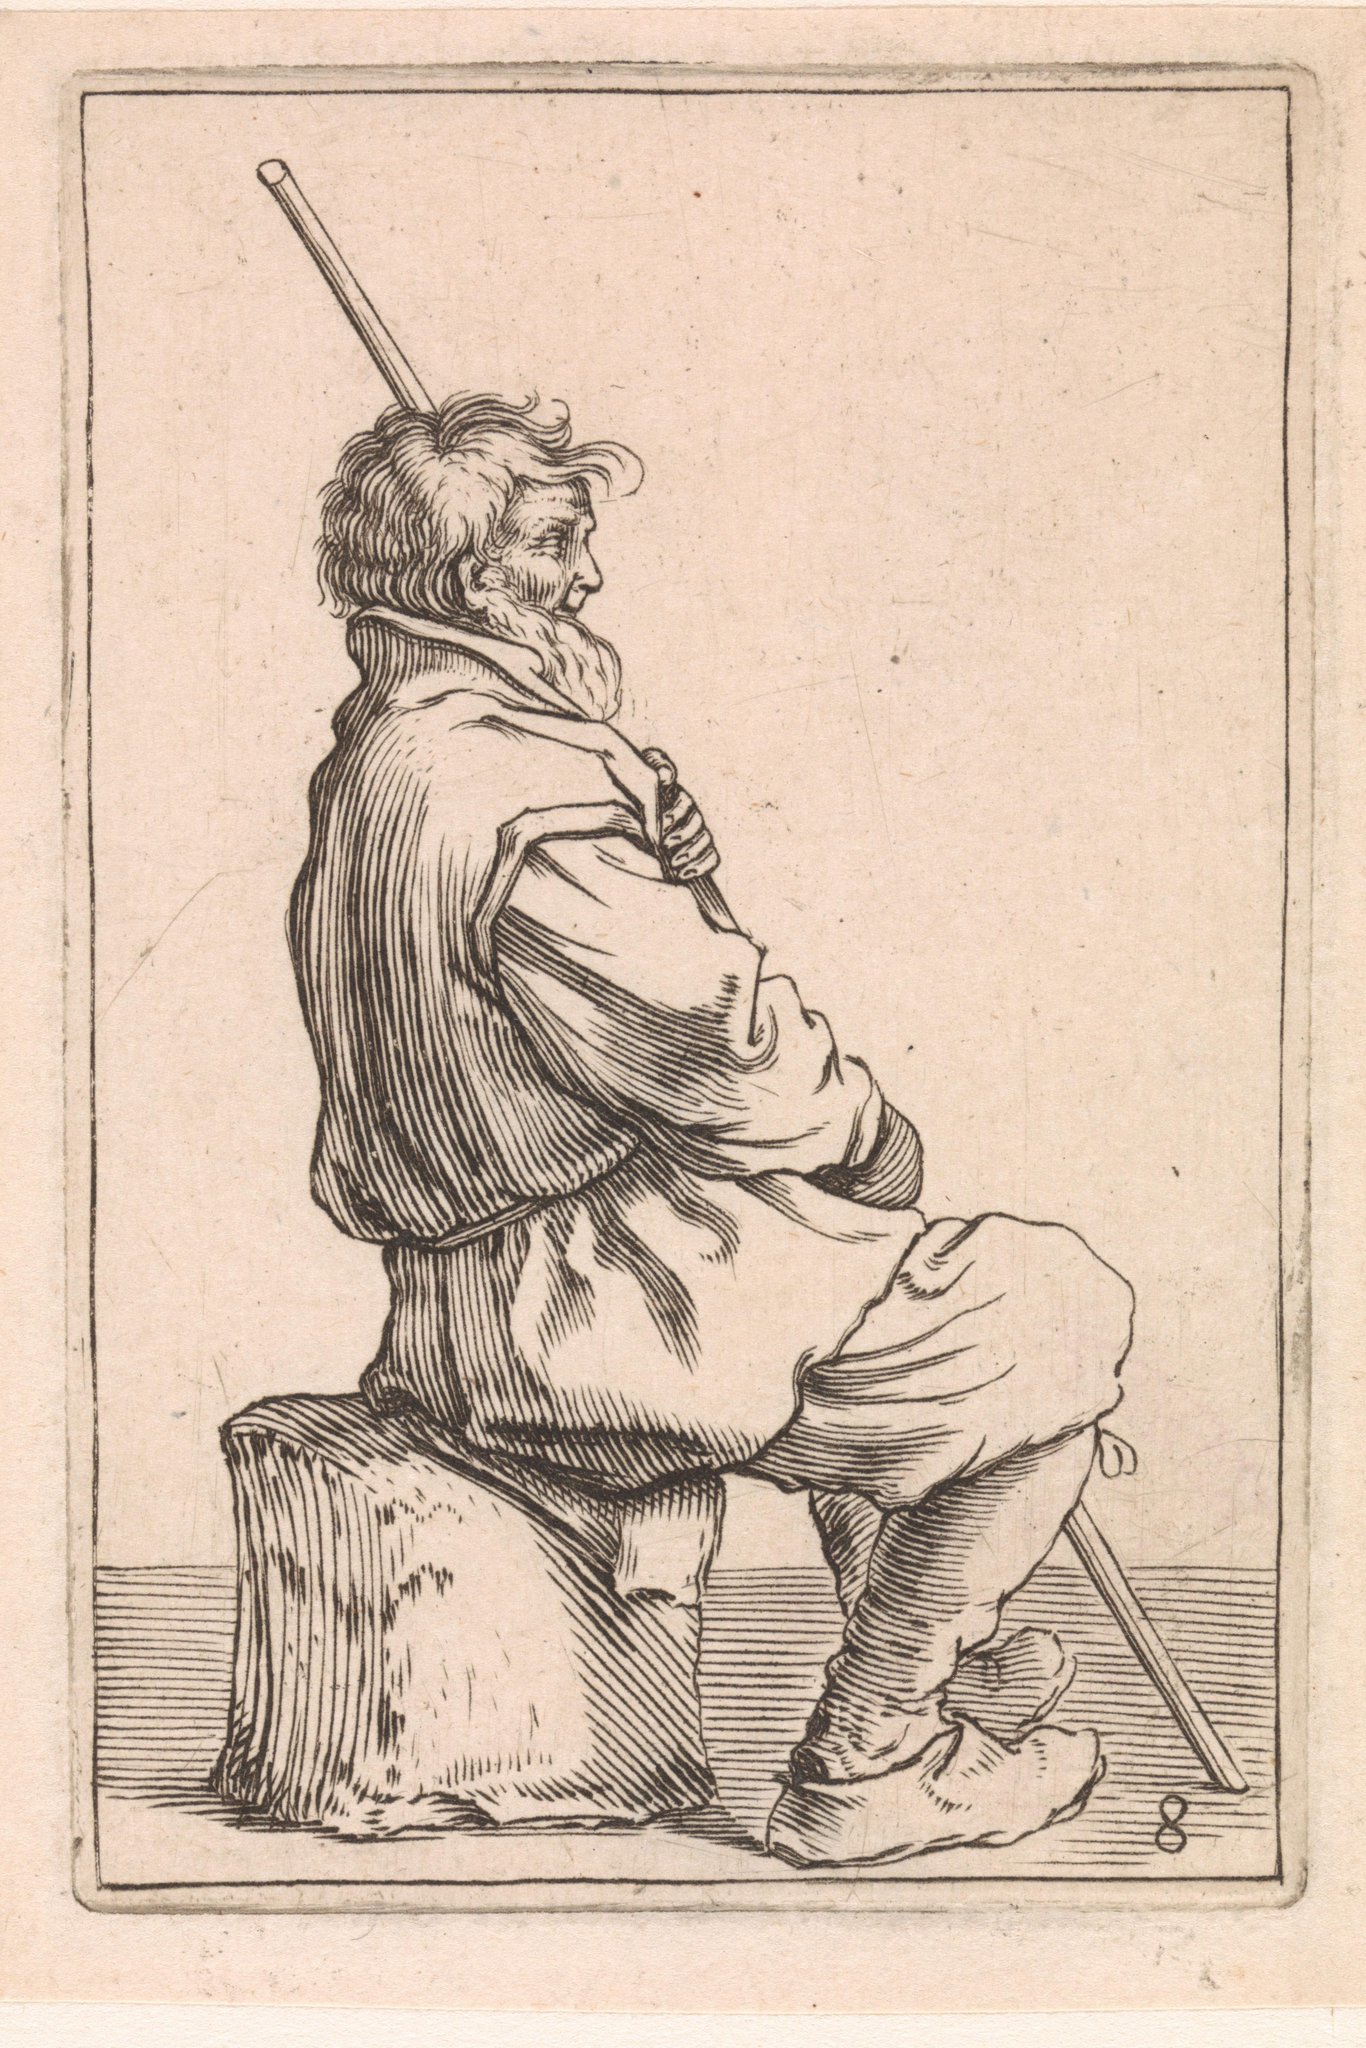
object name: print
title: Zittende man met lange stok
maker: cornelis saftleven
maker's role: draughtsman, painter, print maker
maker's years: 1607-1681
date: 1645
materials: paper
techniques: etching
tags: walking-stick, staff, farmers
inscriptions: collector's mark: Lugt 240